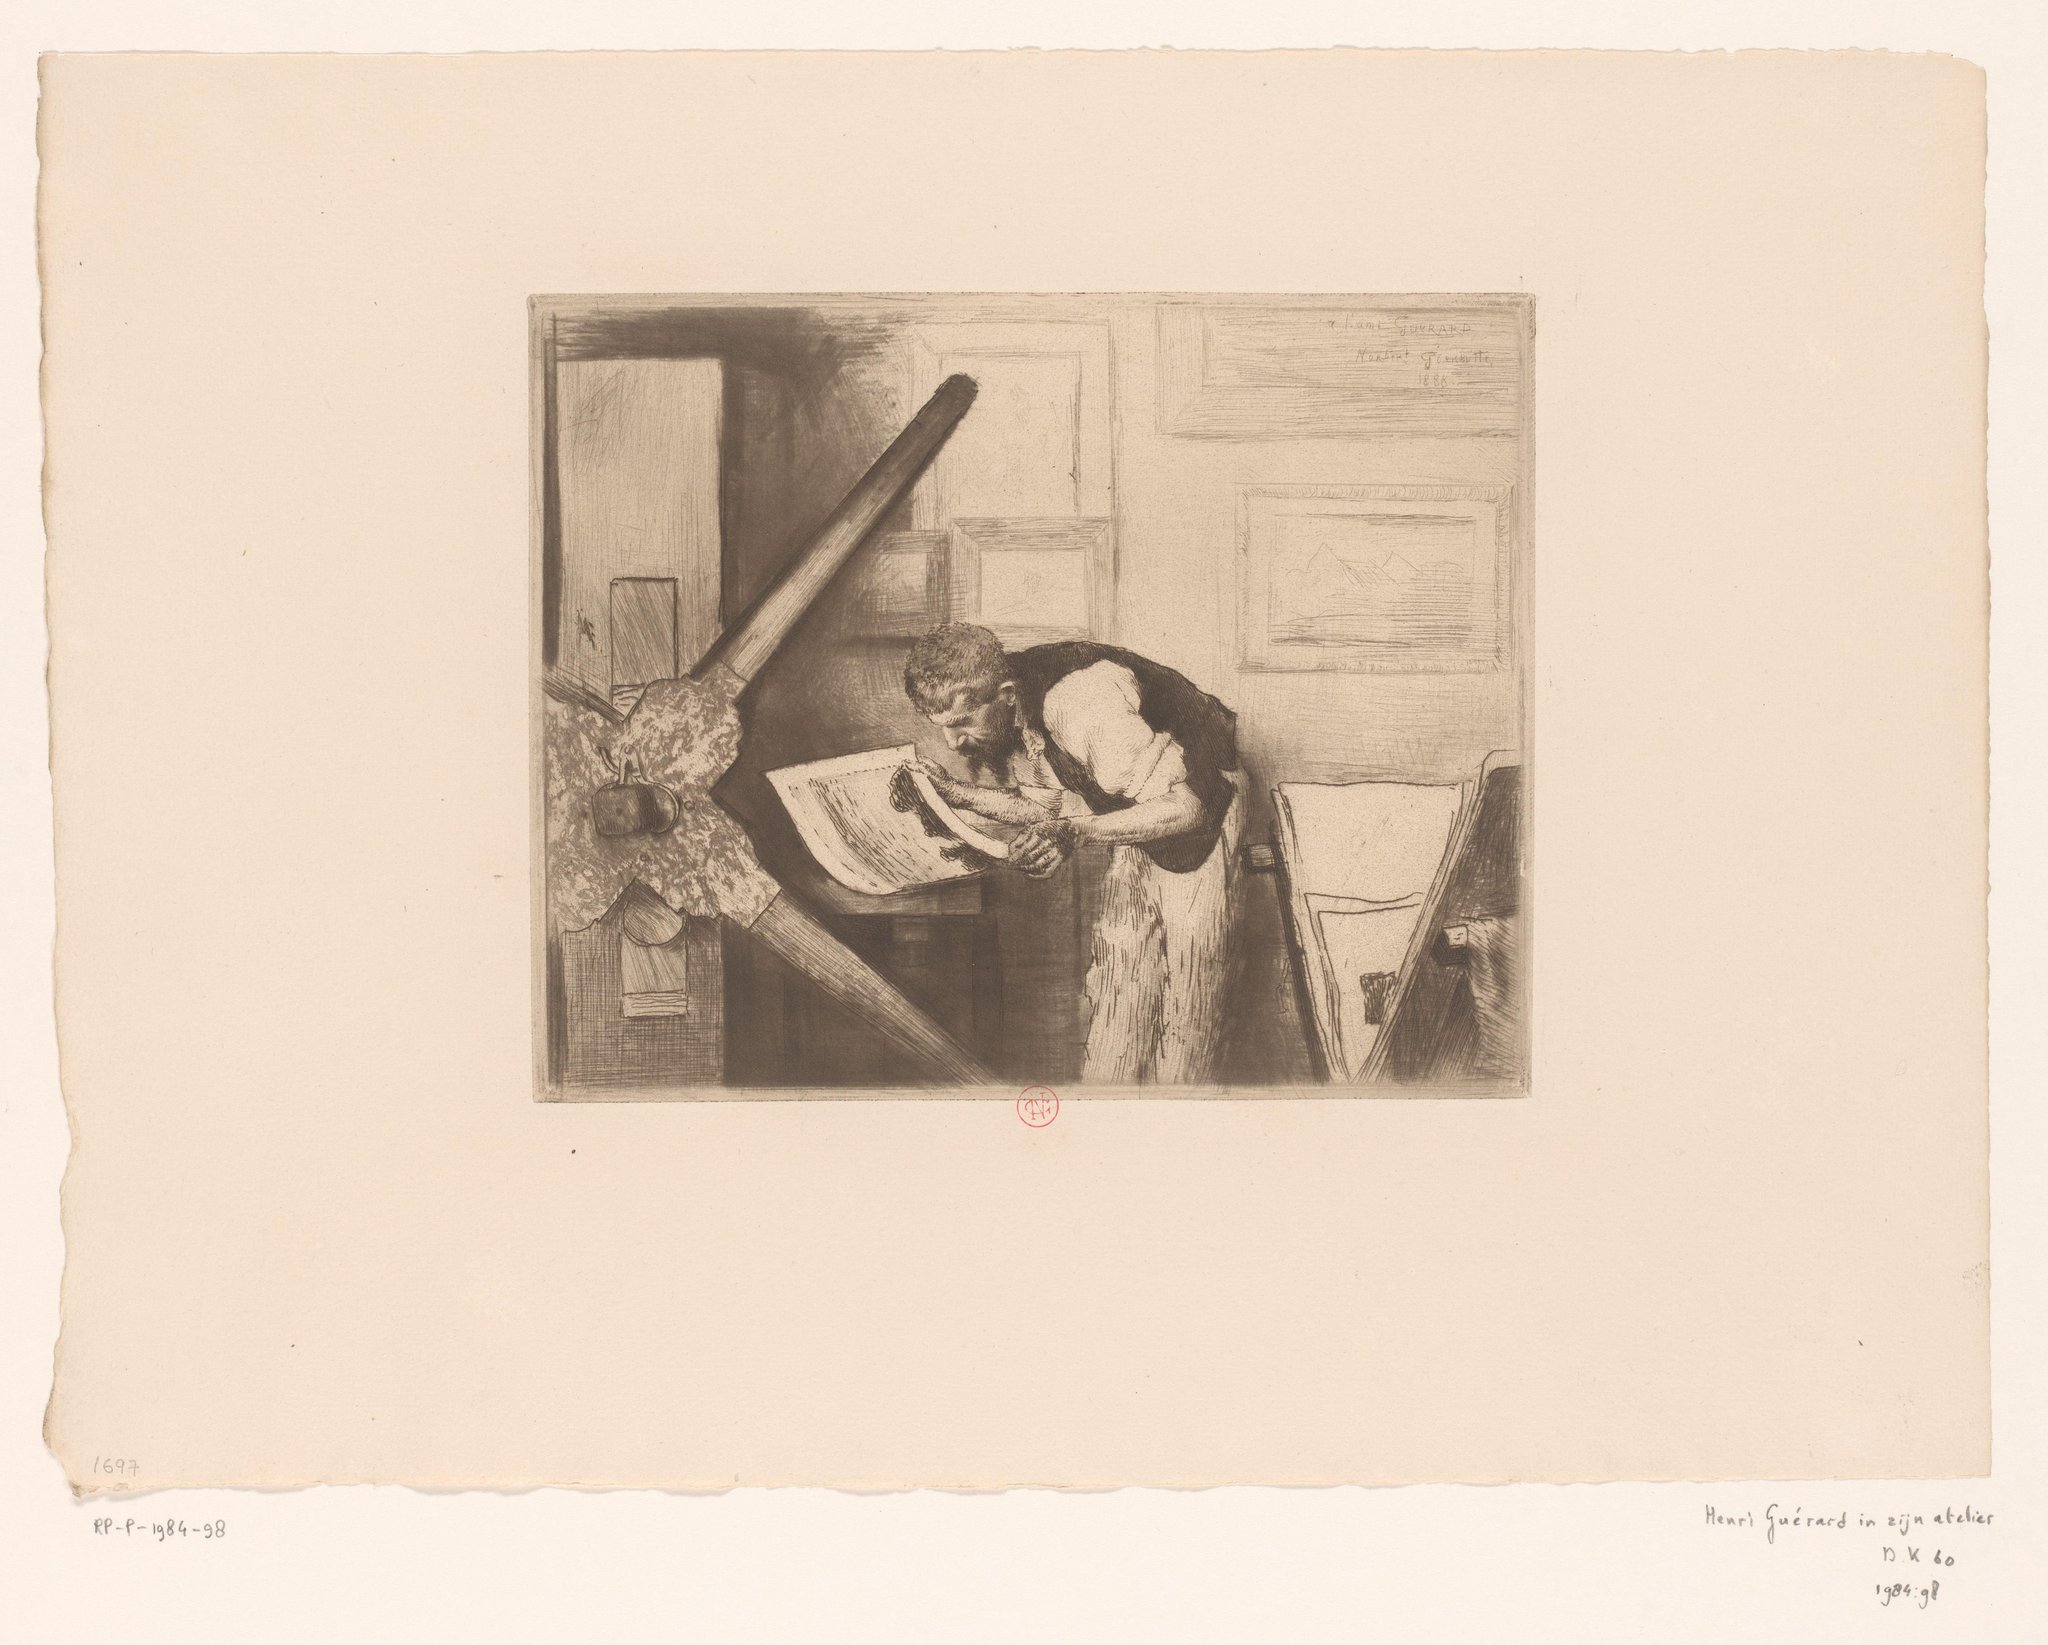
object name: print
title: Portret van Henri Charles Guérard in zijn atelier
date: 1888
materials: paper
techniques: etching, intaglio, roulette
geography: france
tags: paris, henri charles guérard, historical persons, tools, implements of graphic artist, portrait, self-portrait of graphic artist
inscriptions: collector's mark: Lugt 2228, stamp: Lugt 1182, collector's mark: Lugt 2760